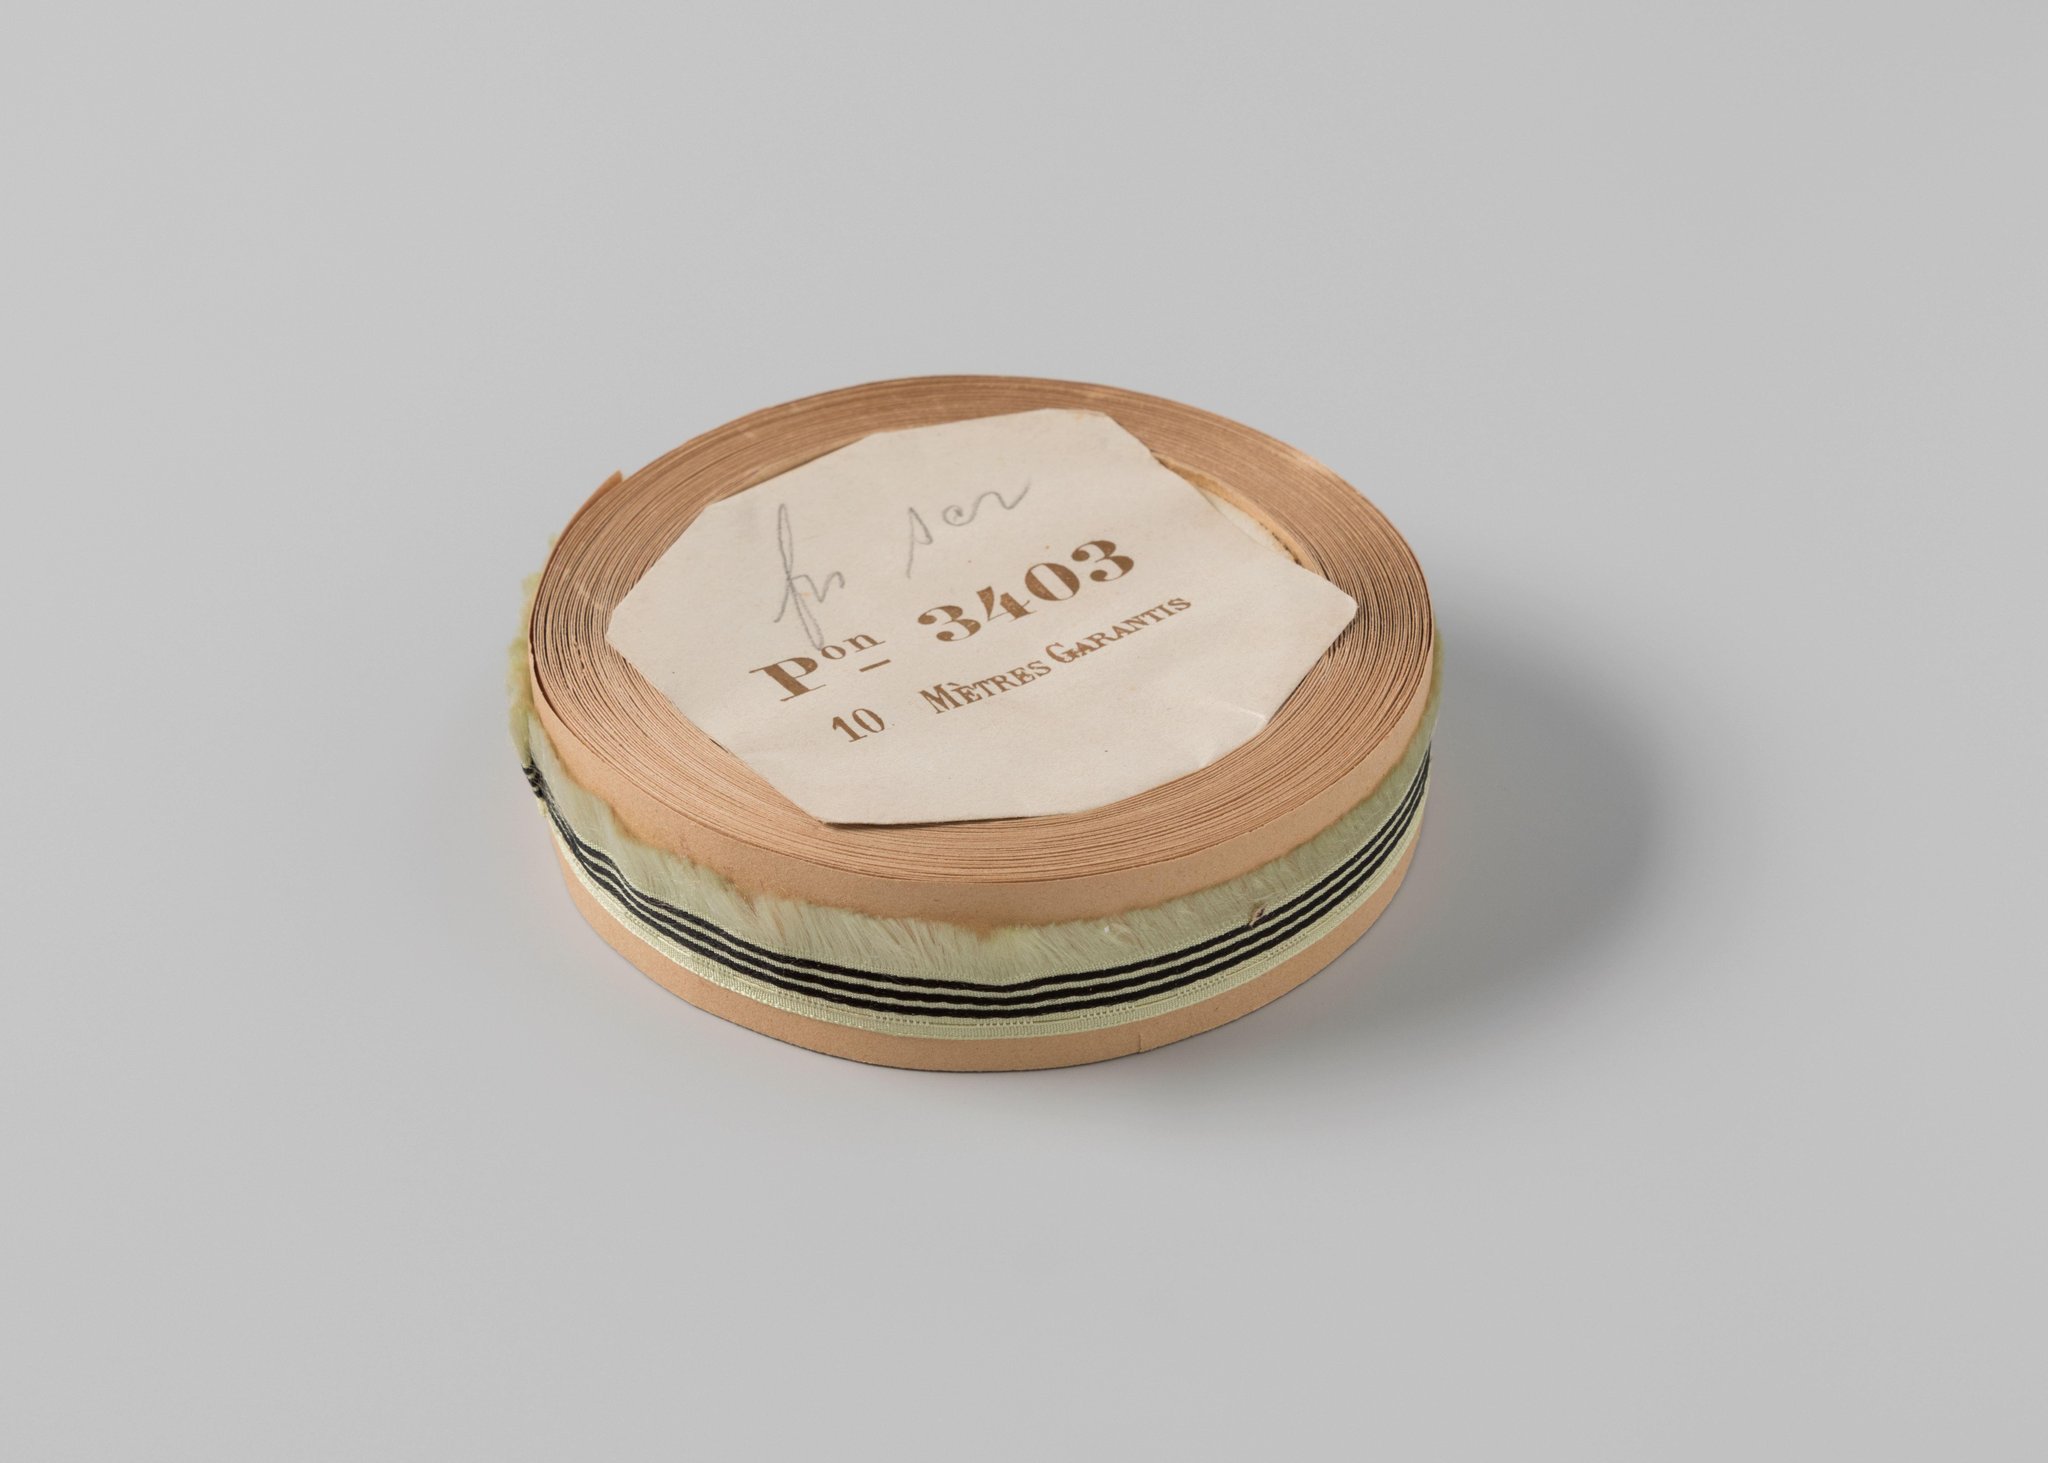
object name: ribbon material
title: Rol met lichtgroen lint met één gerafelde zijde en drie zwarte horizontale strepen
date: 1930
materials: cardboard, paper, textile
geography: france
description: Rol met lichtgroen lint met één gerafelde zijde en drie zwarte horizontale strepen.